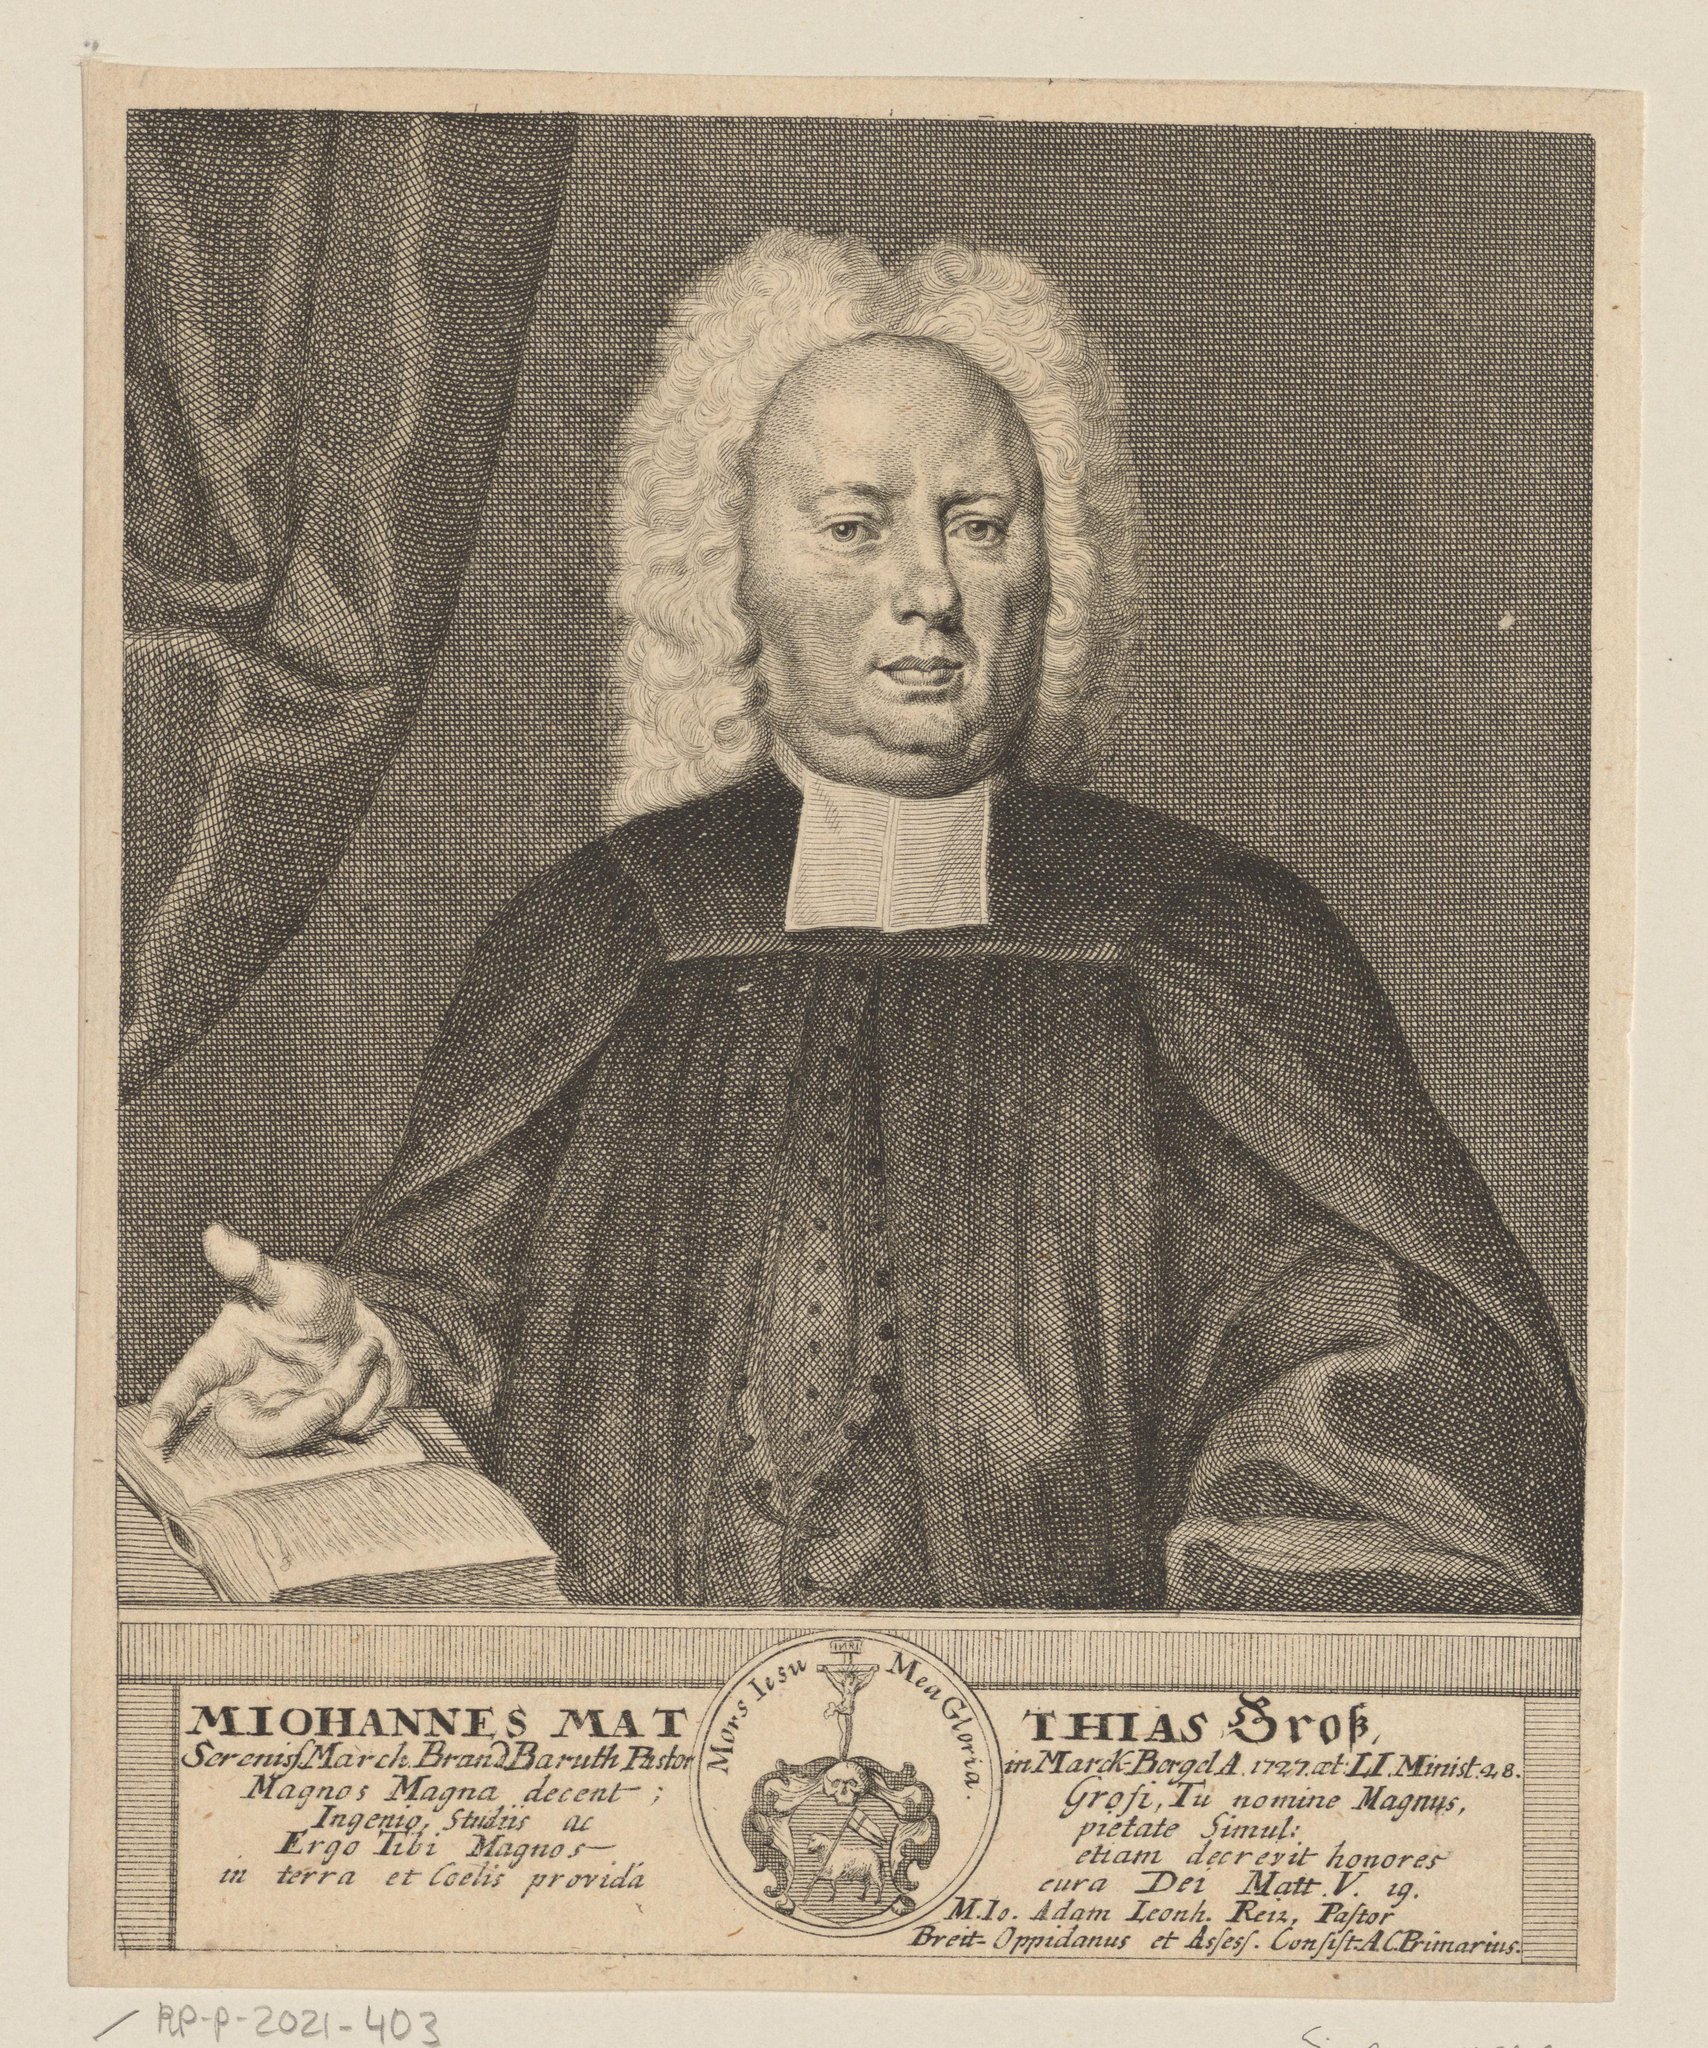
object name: print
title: Portret van Johann Matthias Gross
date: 1727-1753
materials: paper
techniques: engraving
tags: historical persons